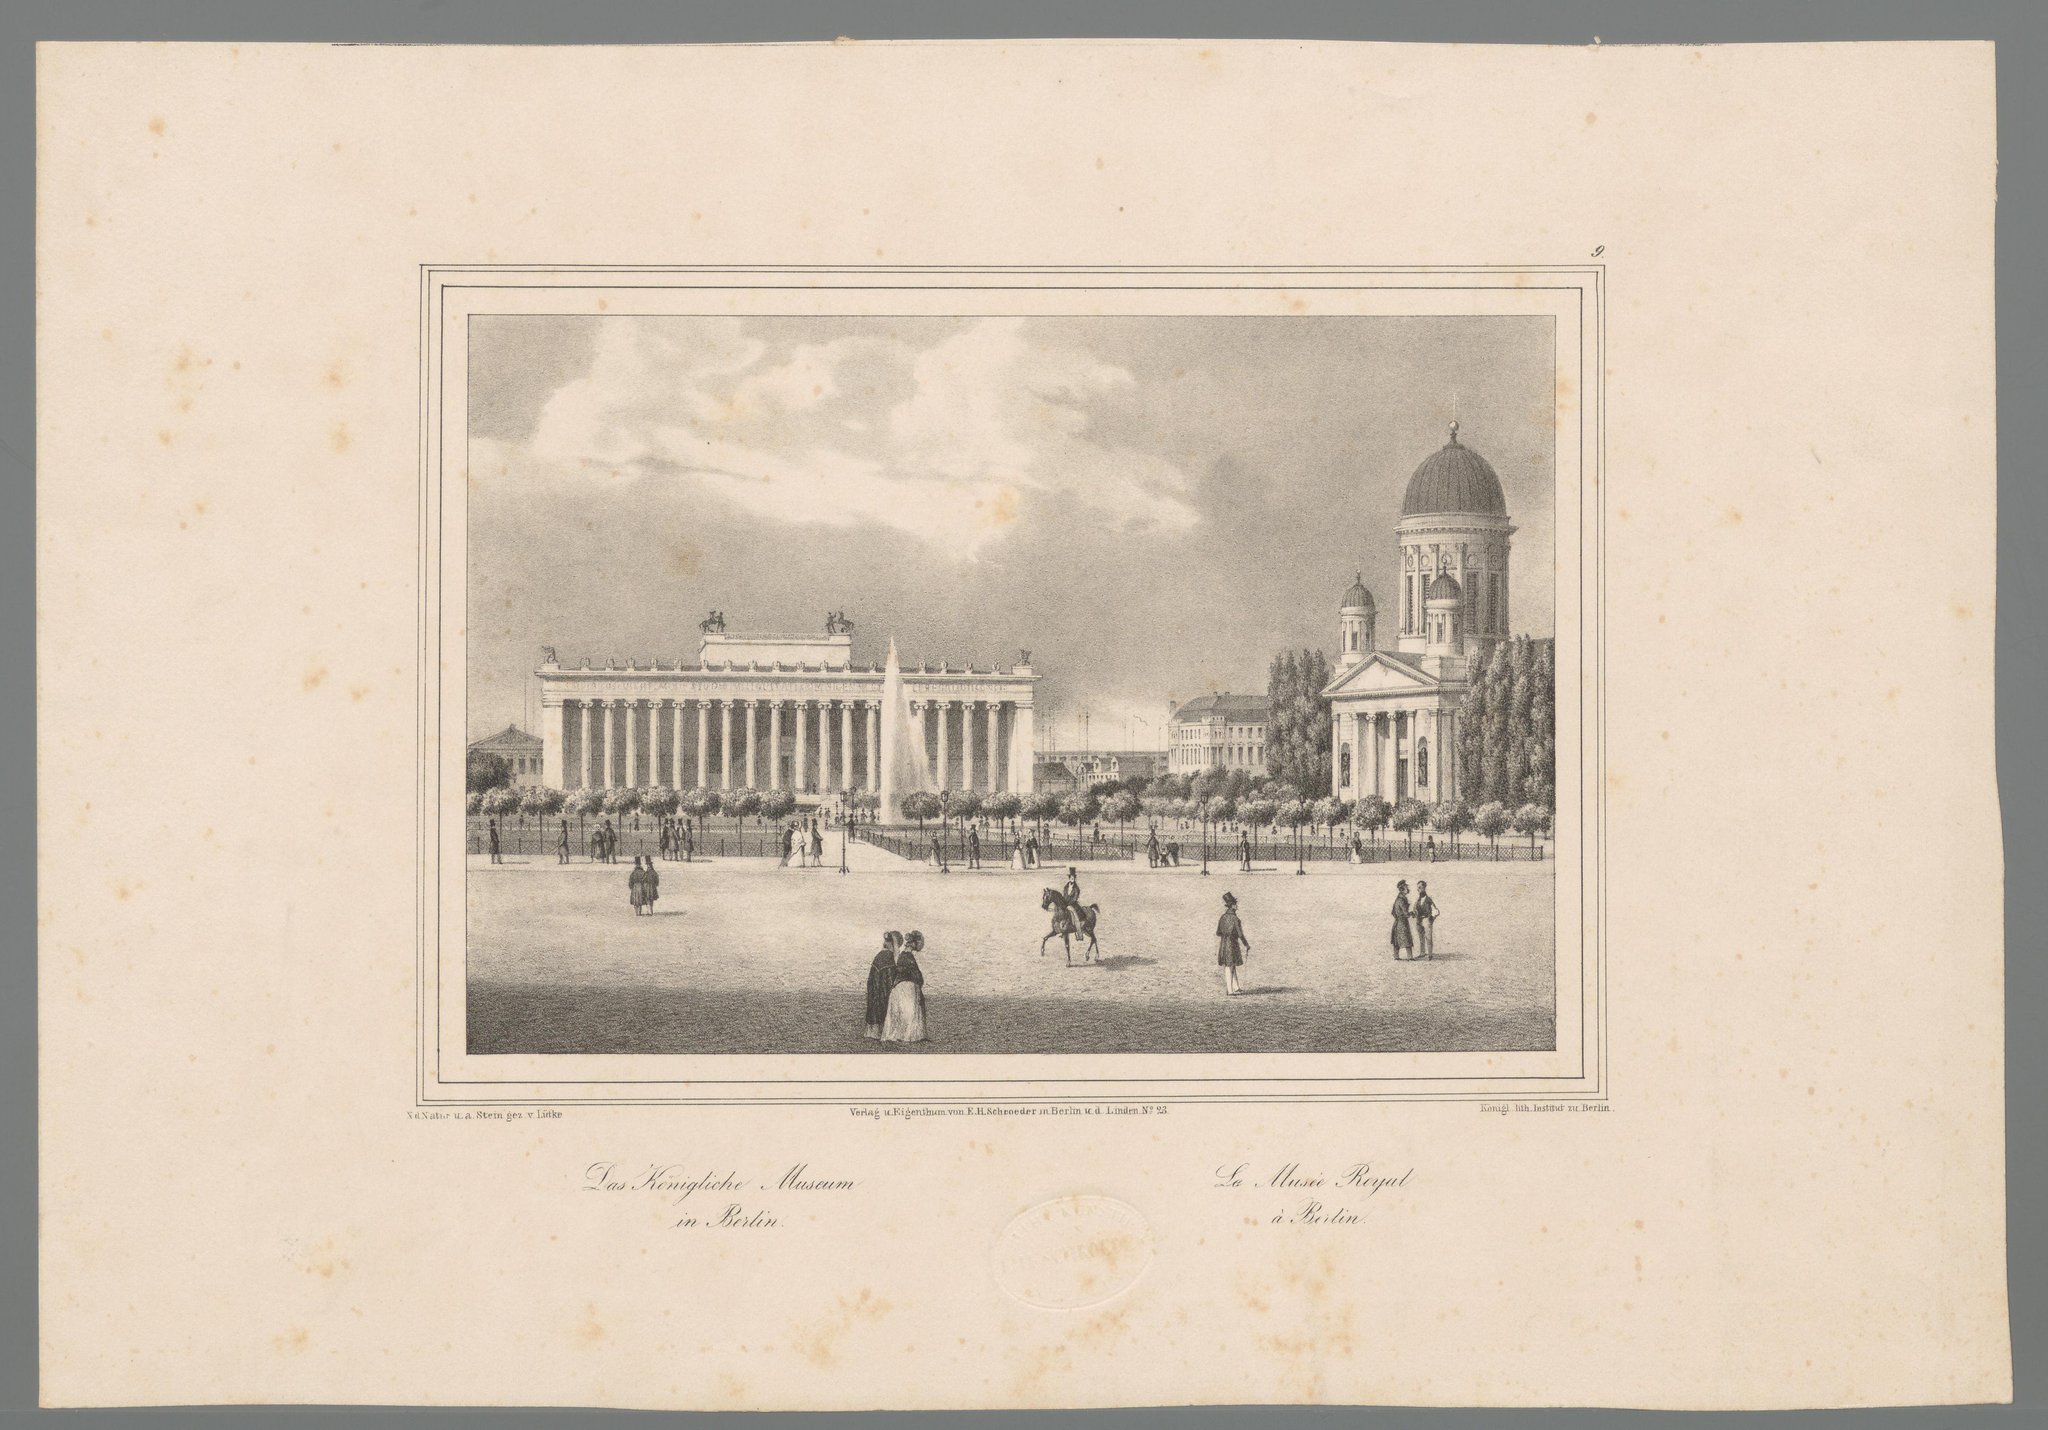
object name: print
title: Das Königliche Museum in Berlin / La Musée Royal à Berlin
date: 1840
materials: paper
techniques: lithograph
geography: berlin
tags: city-view in general; 'veduta', permanent exhibition, museum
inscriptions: collector's mark: Lugt 2228, check stamp: ‘Buch u. Kunsth. von E.H. Schroeder in Berlin’